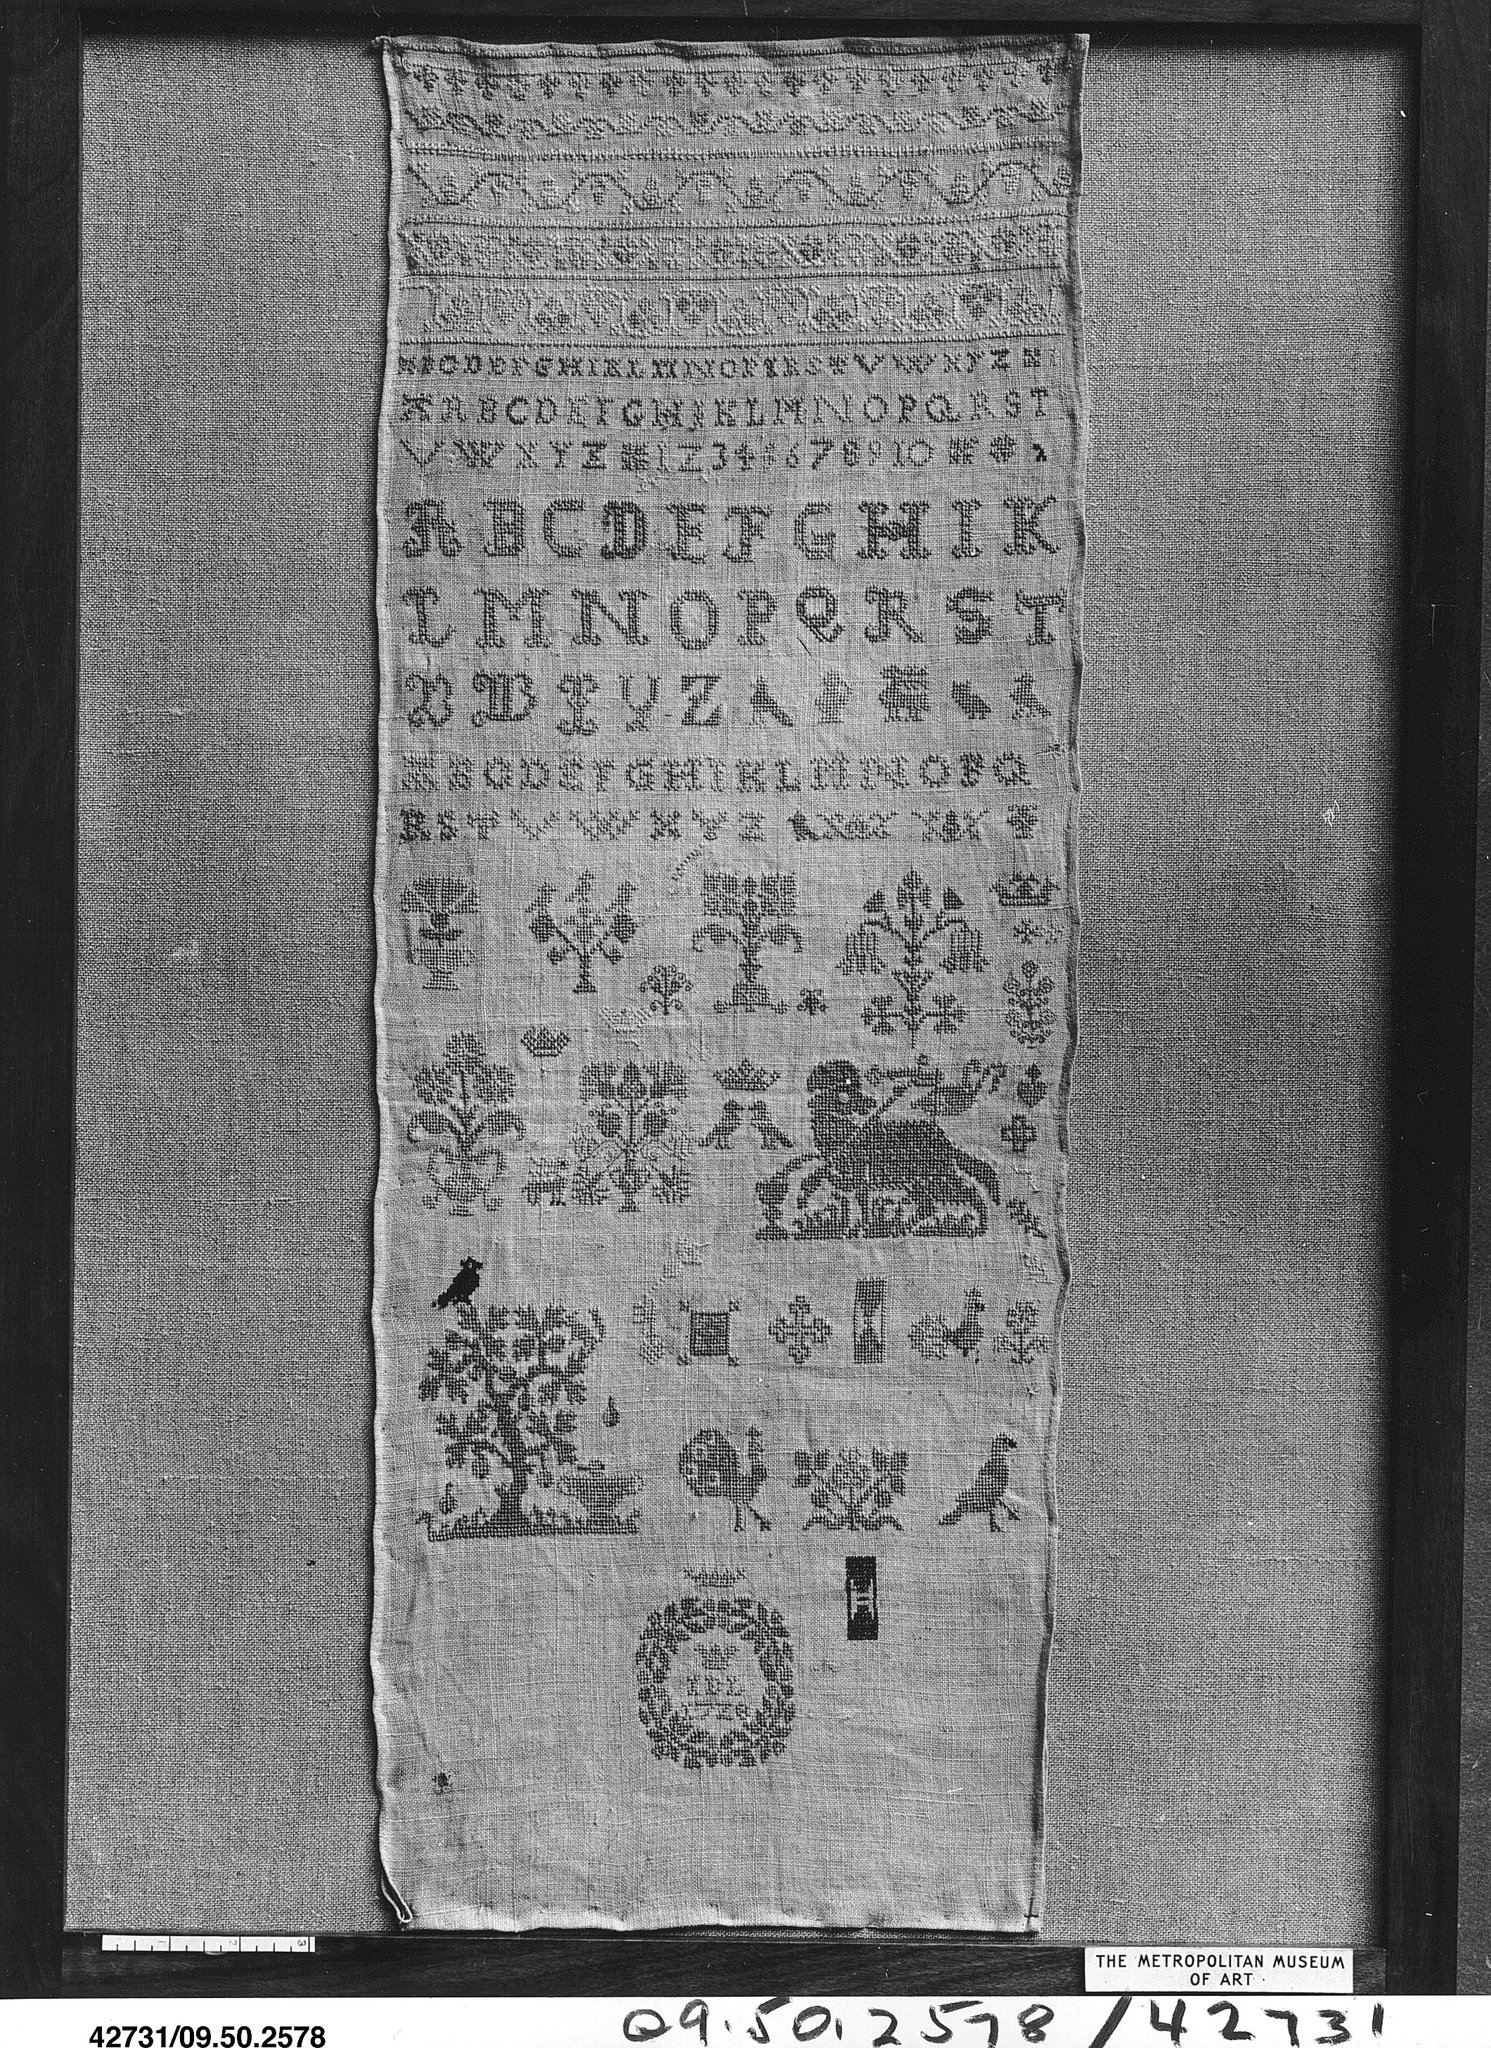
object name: sampler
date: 1728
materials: linen, silk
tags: animals,birds